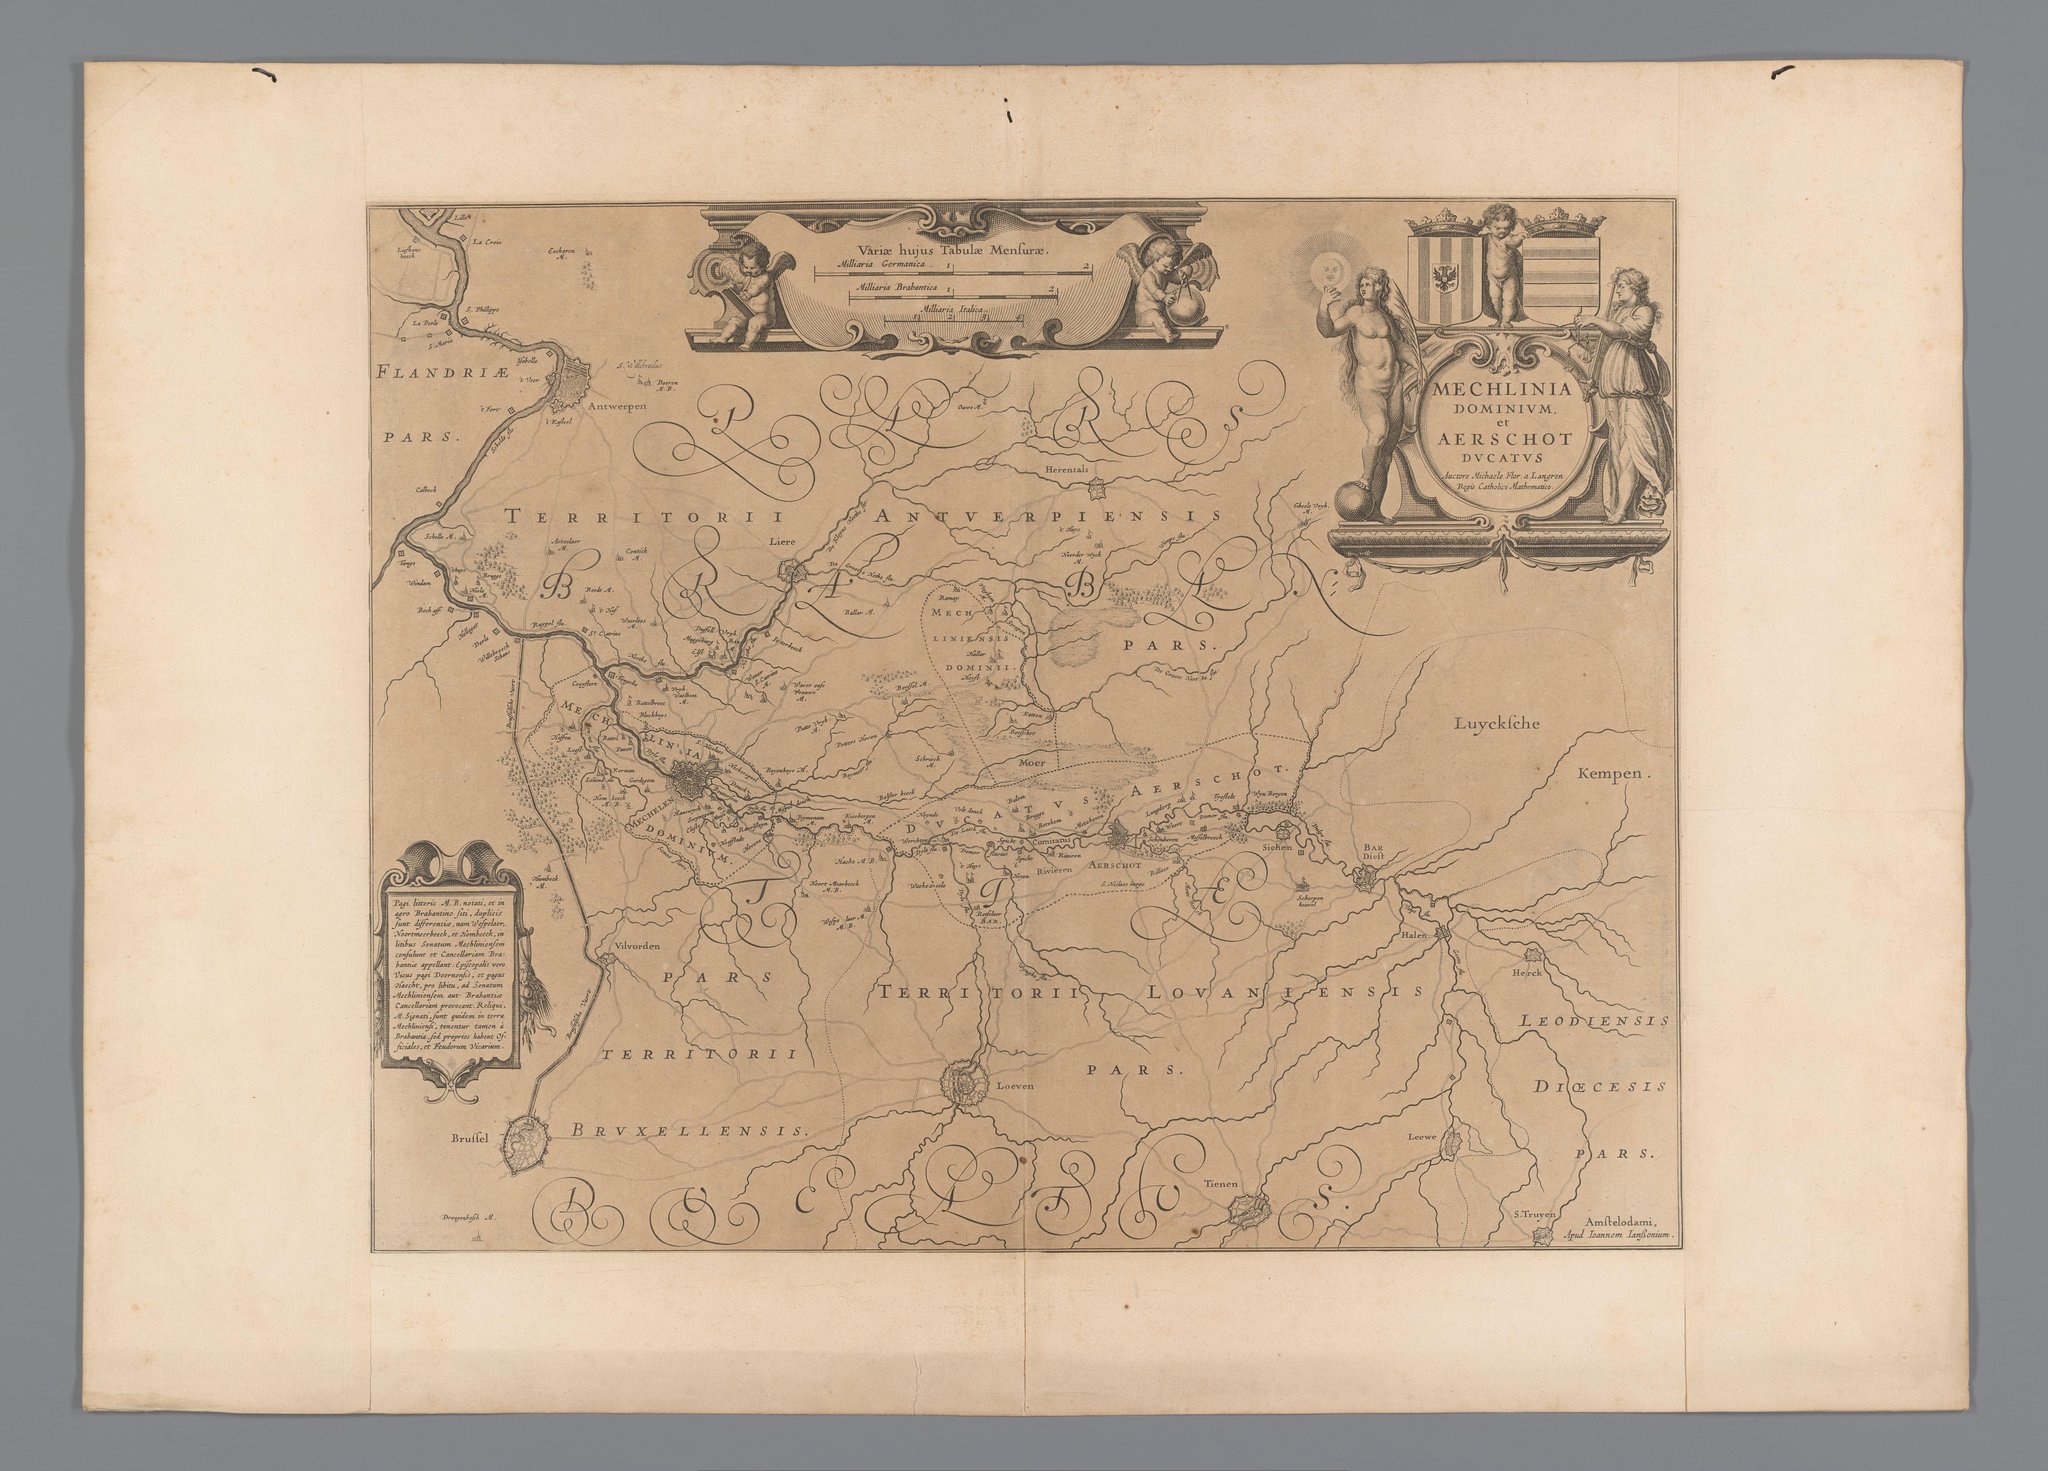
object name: print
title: Mechlinia dominium et Aerschot ducatus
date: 1638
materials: paper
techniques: engraving, etching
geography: amsterdam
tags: coat of arms (as symbol of the state, etc.) (+ city; municipal), maps of separate countries or regions, justitia (justice) as roman personification, truth; 'verità' (ripa), coat of arms (as symbol of the state, etc.) (+ province; provincial), mechelen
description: Kaart van een deel van Vlaanderen, het gebied rond Mechelen en Aarschot. Rechtsboven de titelcartouche met daarbovenop links het wapen van Mechelen en rechts een variant van het wapen van Leuven. Links van de titelcartouche een allegorie van de waarheid, rechts Justitia. Bovenin de kaart een cartouche met drie schaalstokken: 2 Milliaria Germanica / 2 Milliaria Brabantica / 4 Milliaria Italica. Linksonder een cartouche met tekst.